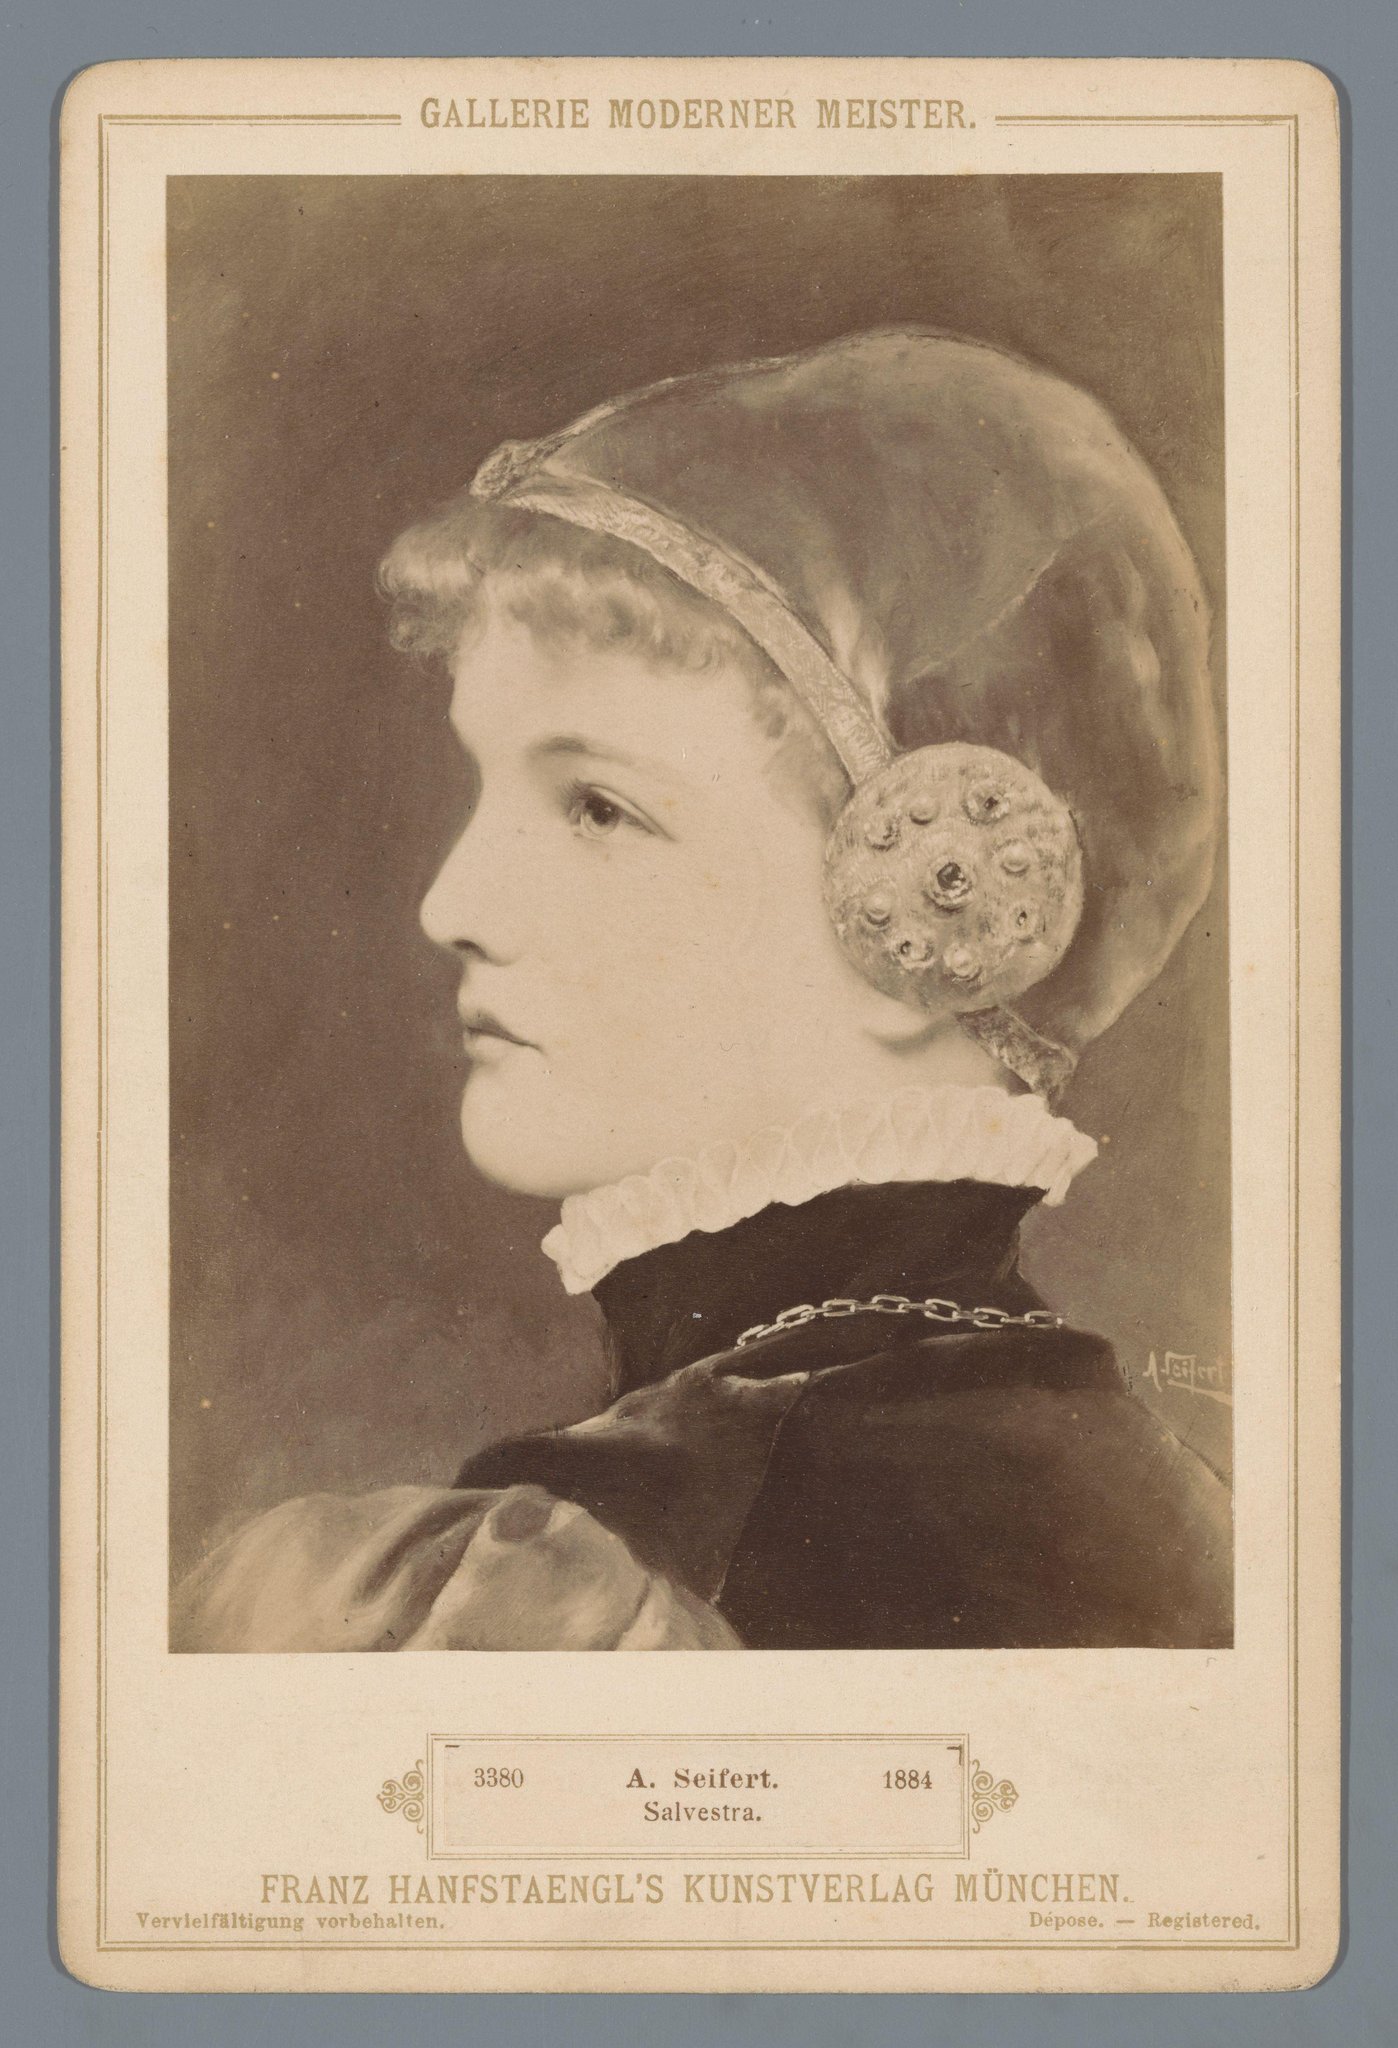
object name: reproduction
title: Salvestra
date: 1870-1900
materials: cardboard, photographic support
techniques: albumen print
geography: munich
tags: adult woman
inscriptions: number: ‘3380’